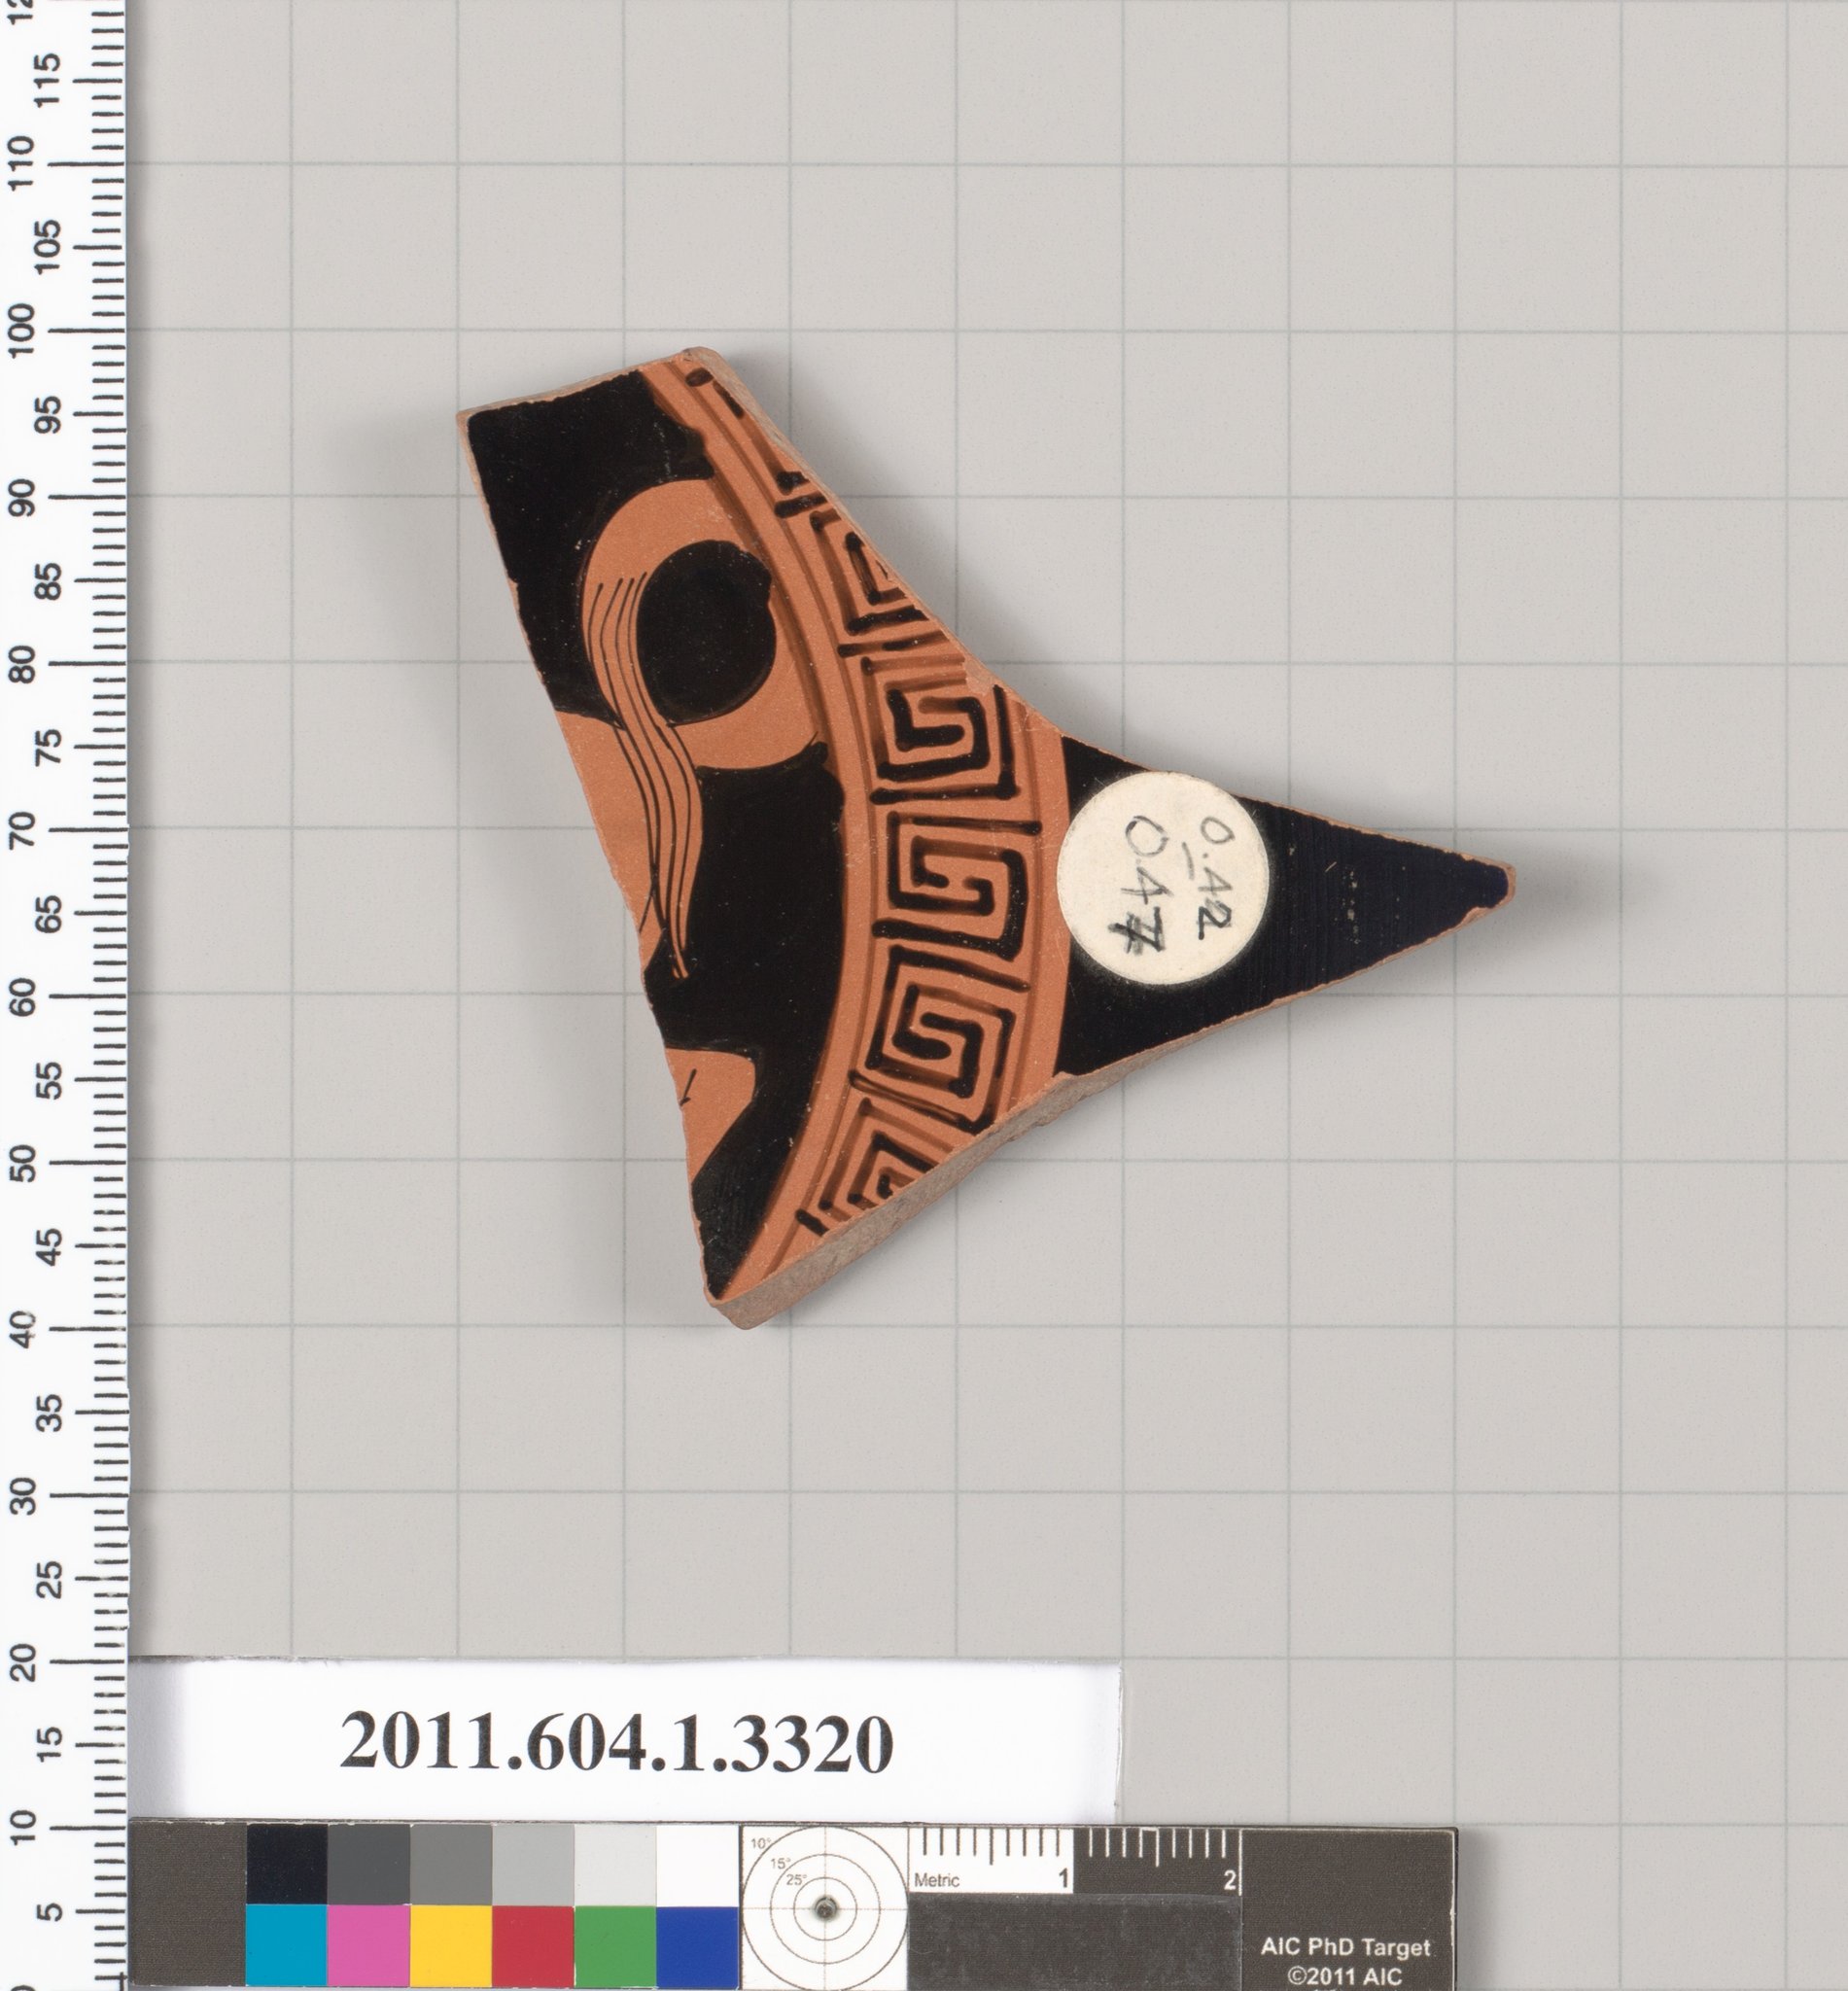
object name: kylix fragment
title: Terracotta fragment of a kylix (drinking cup)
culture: greek, attic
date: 475-451 BCE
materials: terracotta